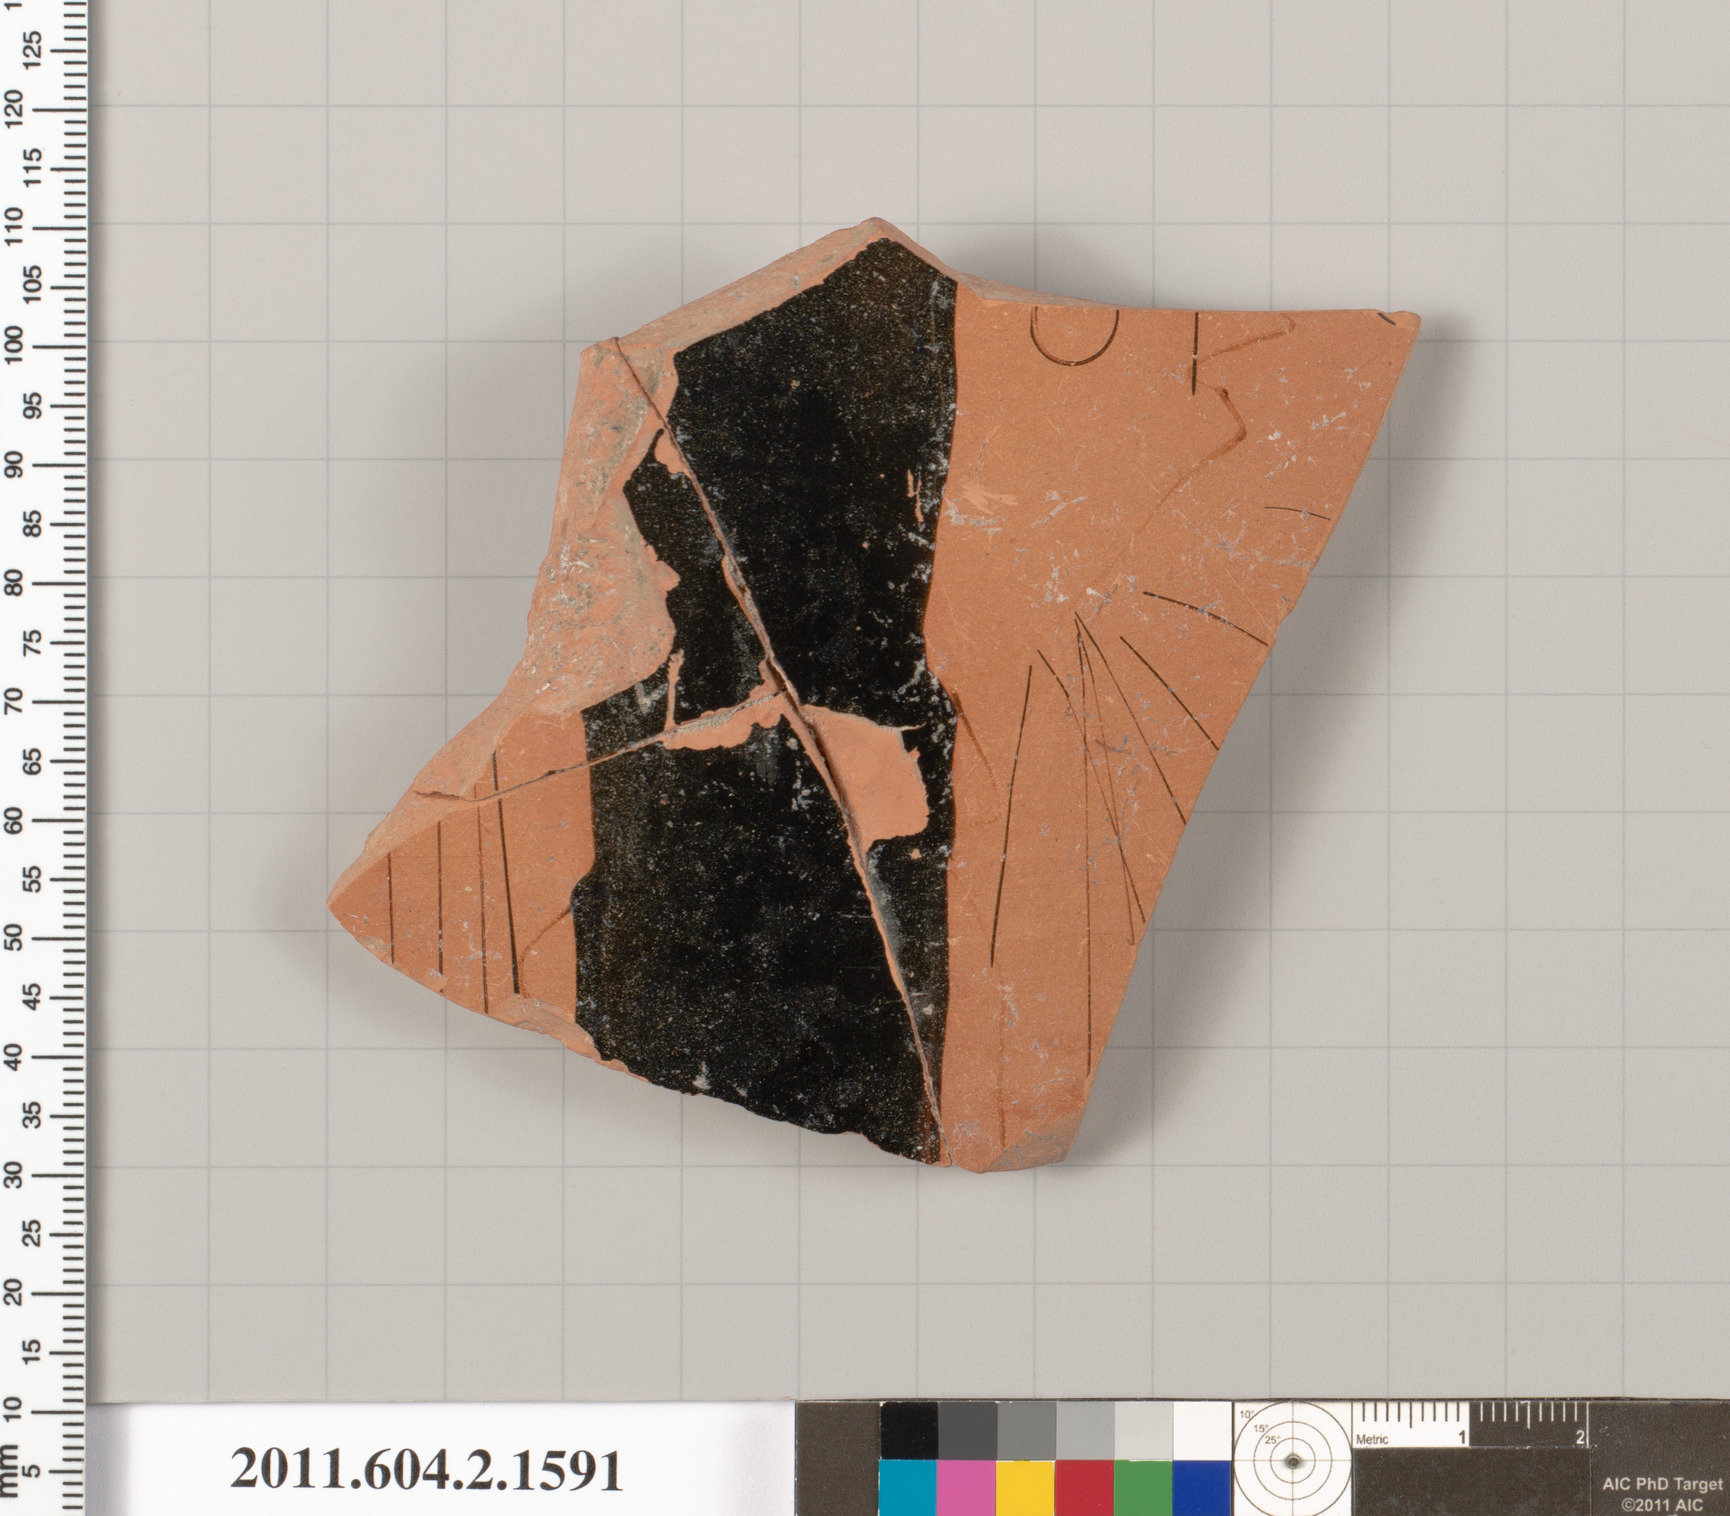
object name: skyphos fragment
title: Terracotta fragment of a skyphos (deep drinking cup)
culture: greek, attic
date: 460-440 BCE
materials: terracotta